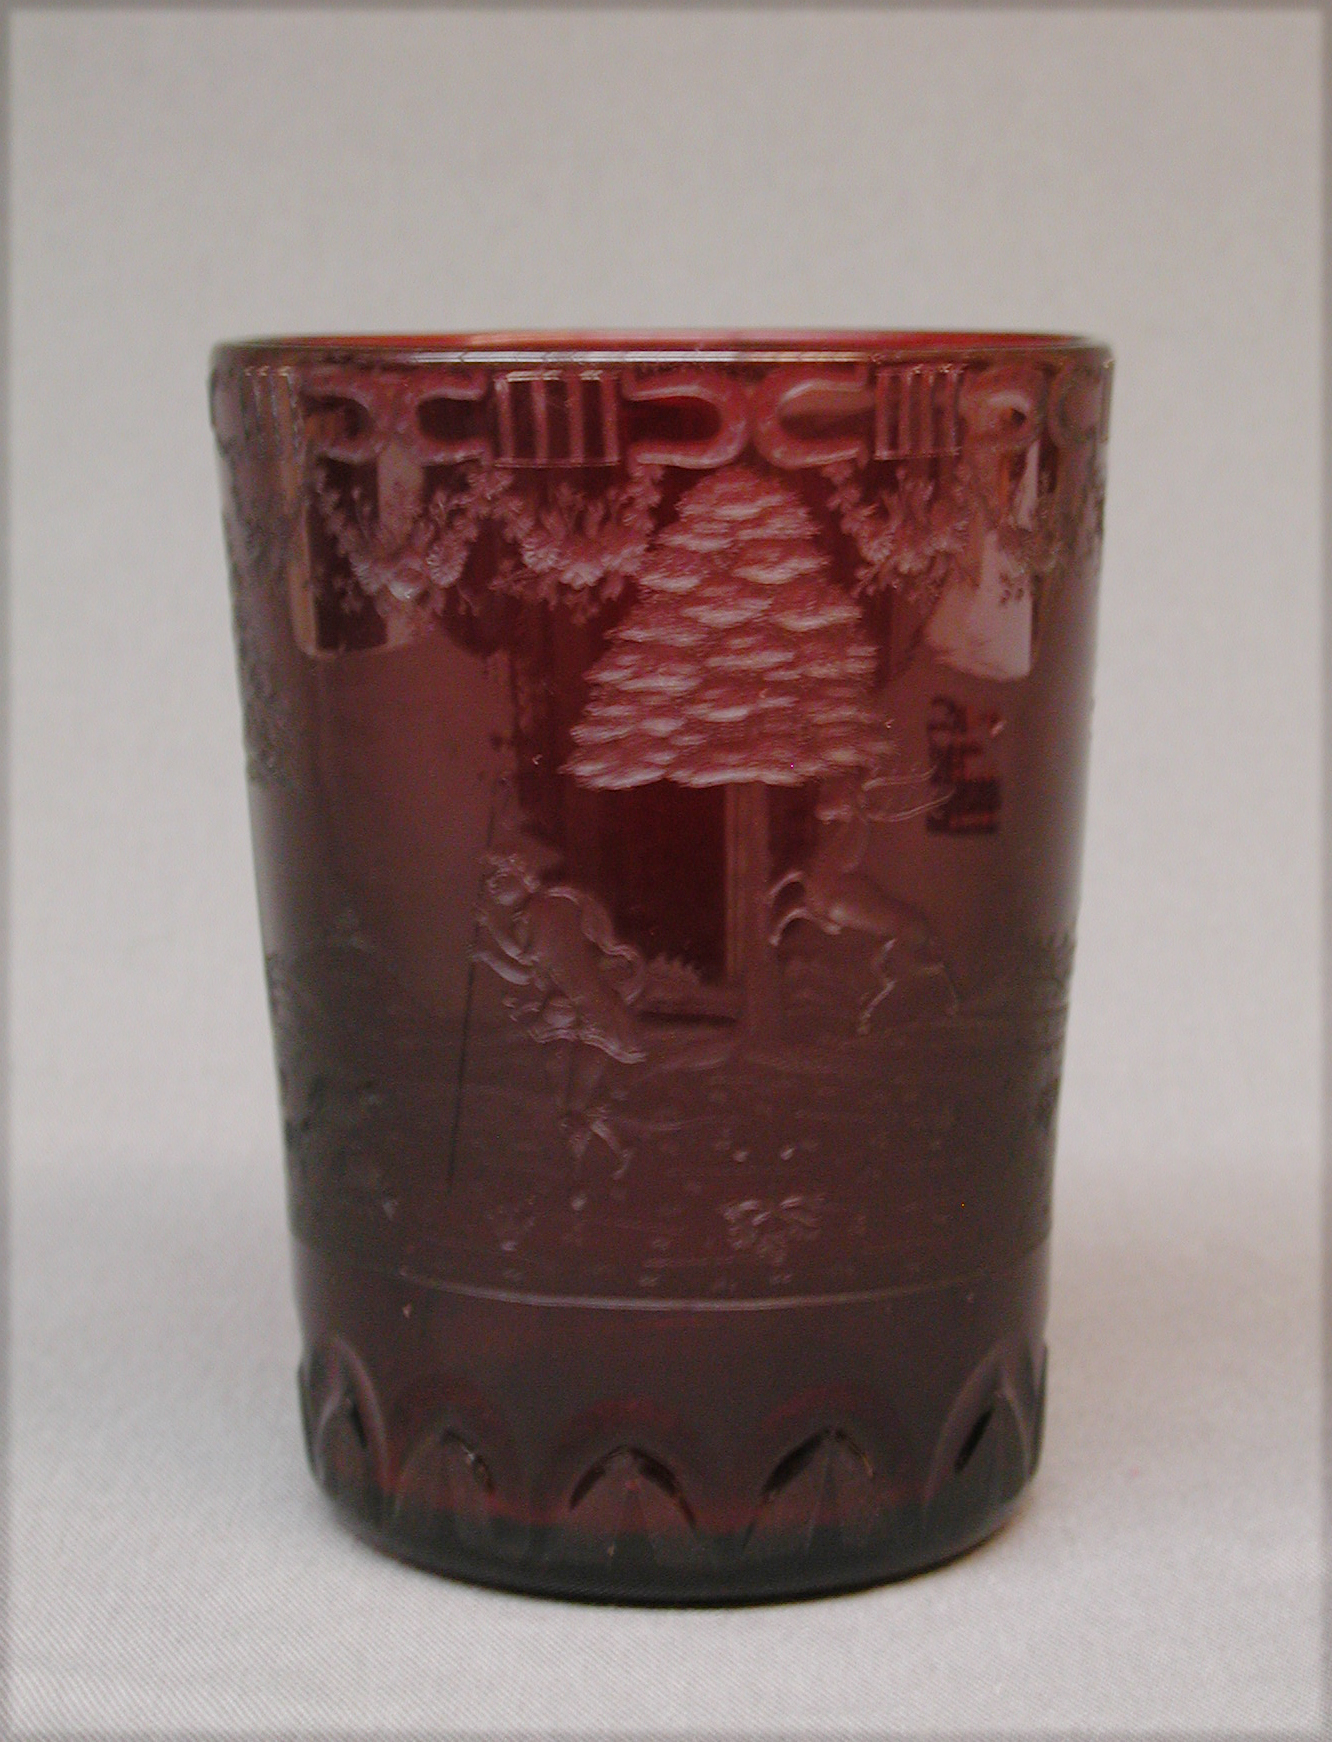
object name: beaker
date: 1700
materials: glass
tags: human figures,deer